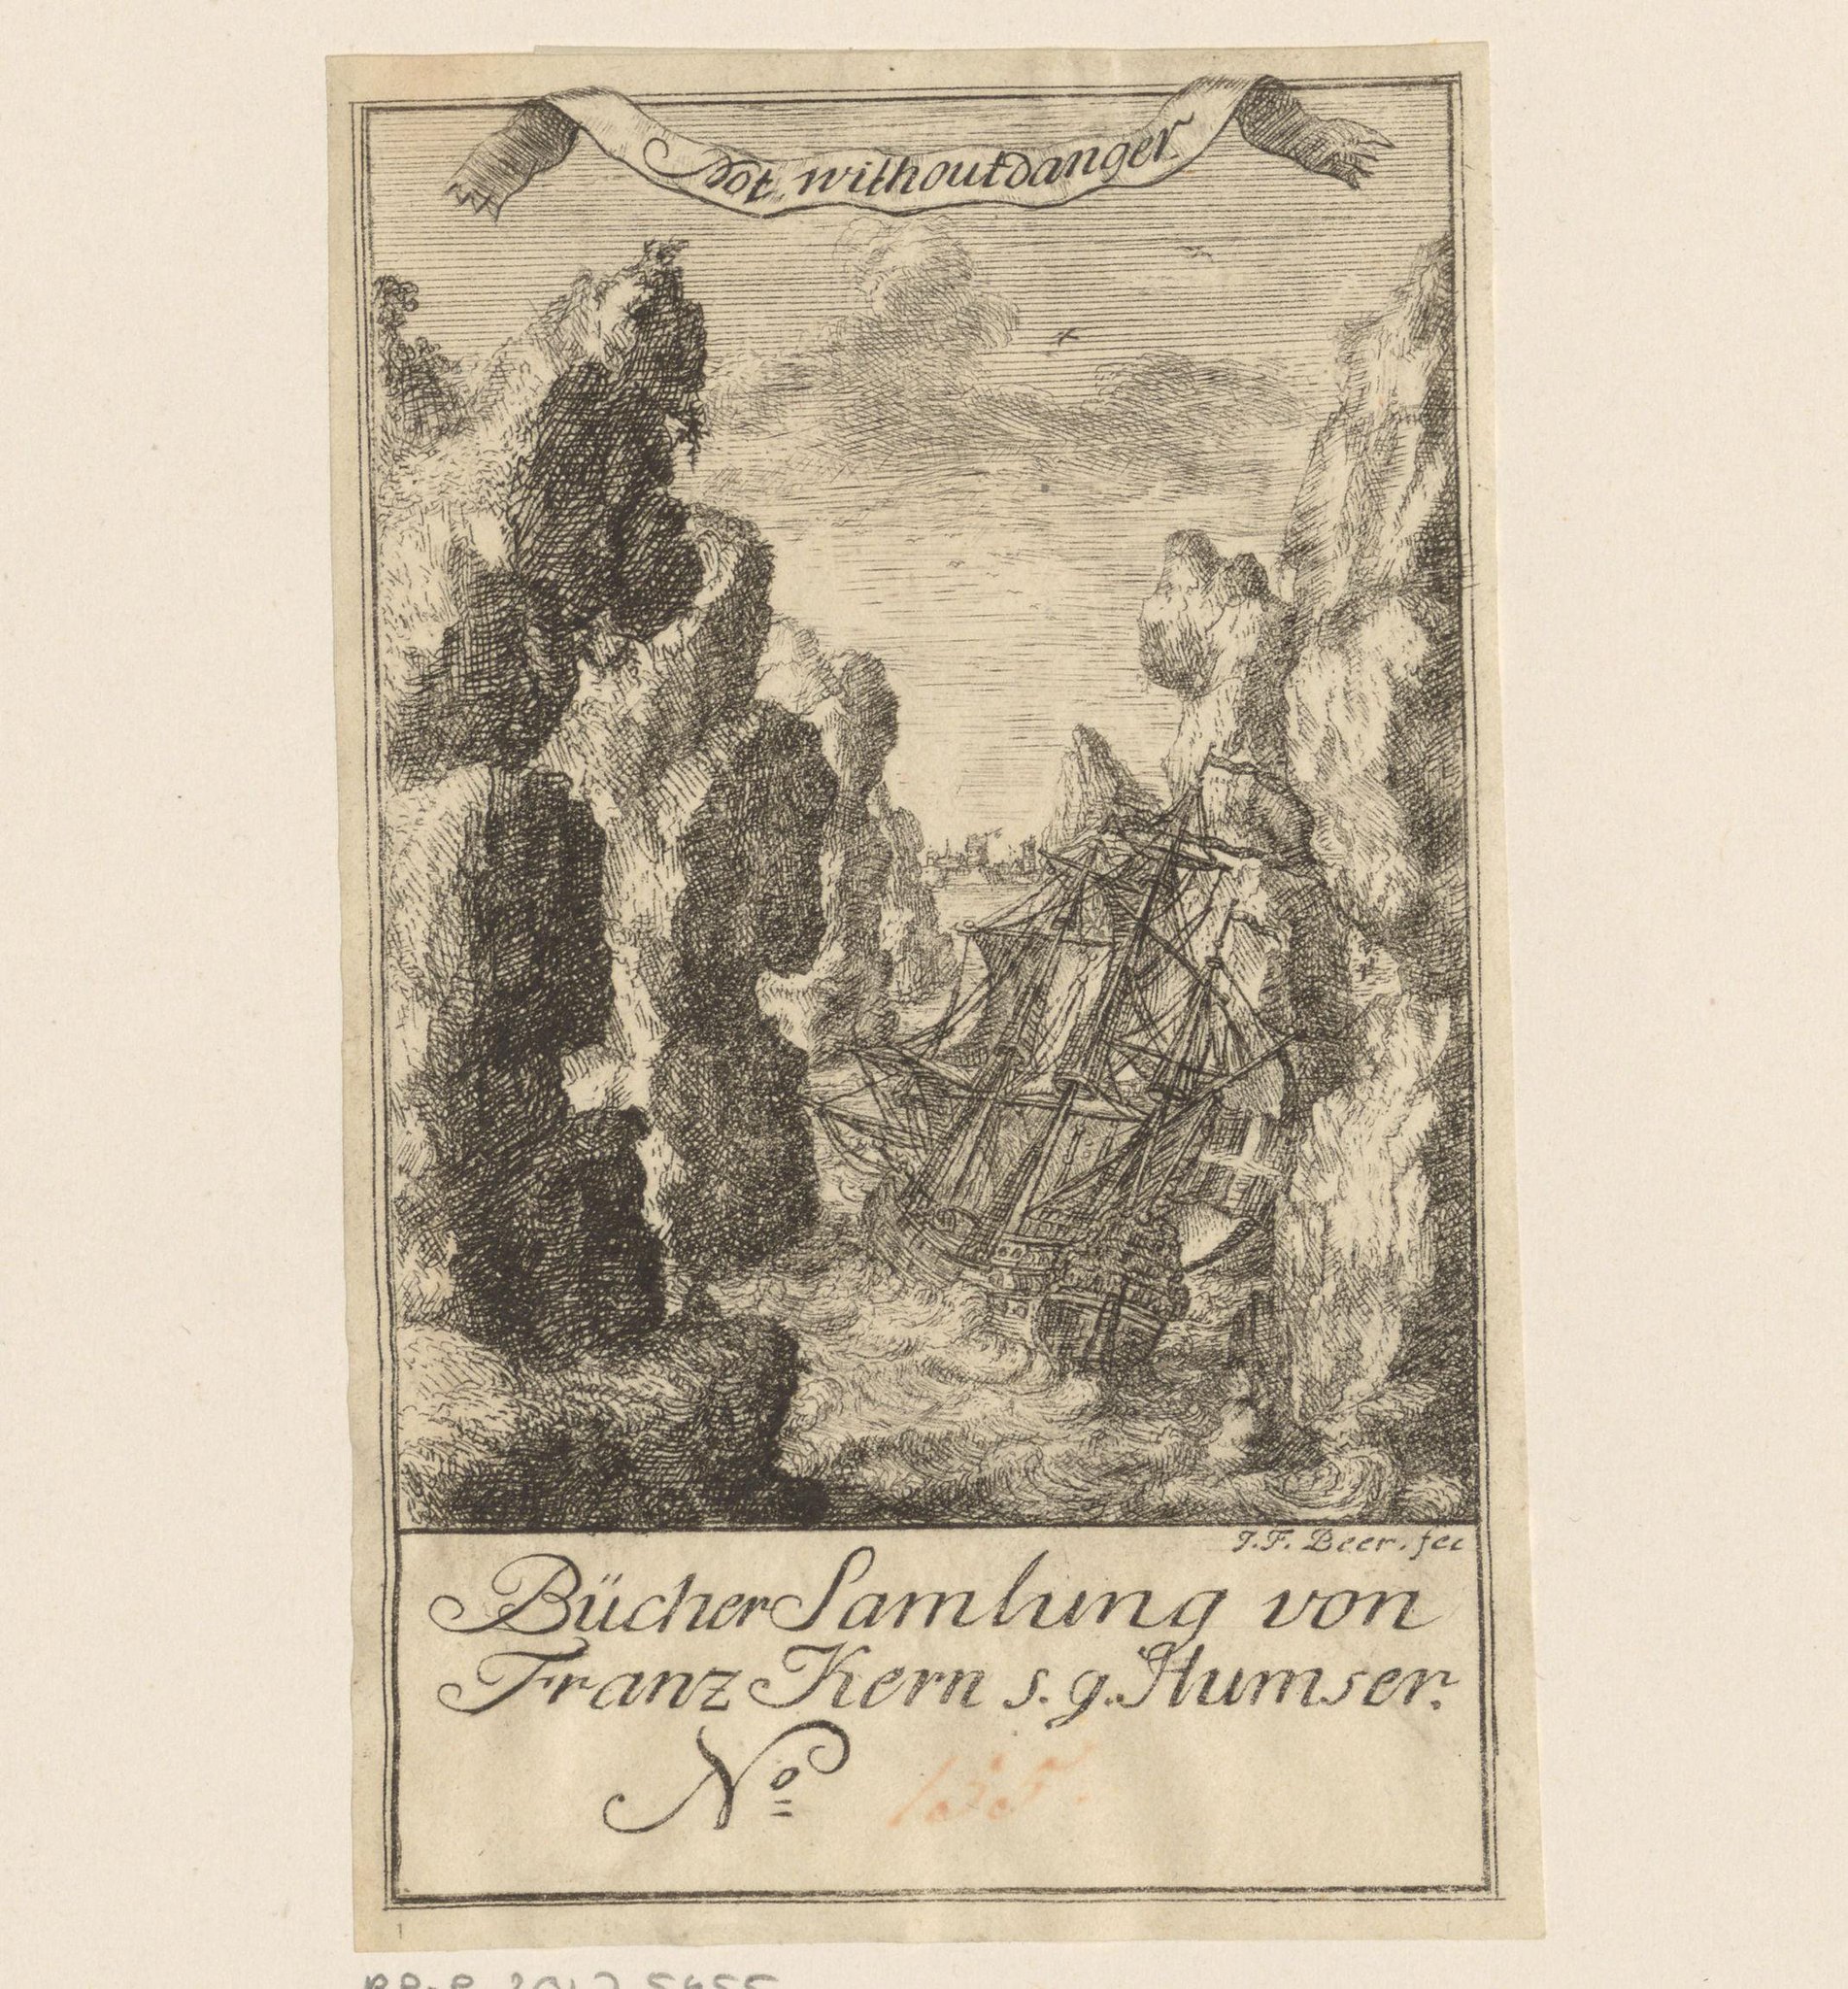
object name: bookplate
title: Not without danger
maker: johann friedrich beer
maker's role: print maker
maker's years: 1741-1804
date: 1750-1849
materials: paper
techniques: etching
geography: germany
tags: sailing-ship, sailing-boat, rocks, sea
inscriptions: number: ‘135’